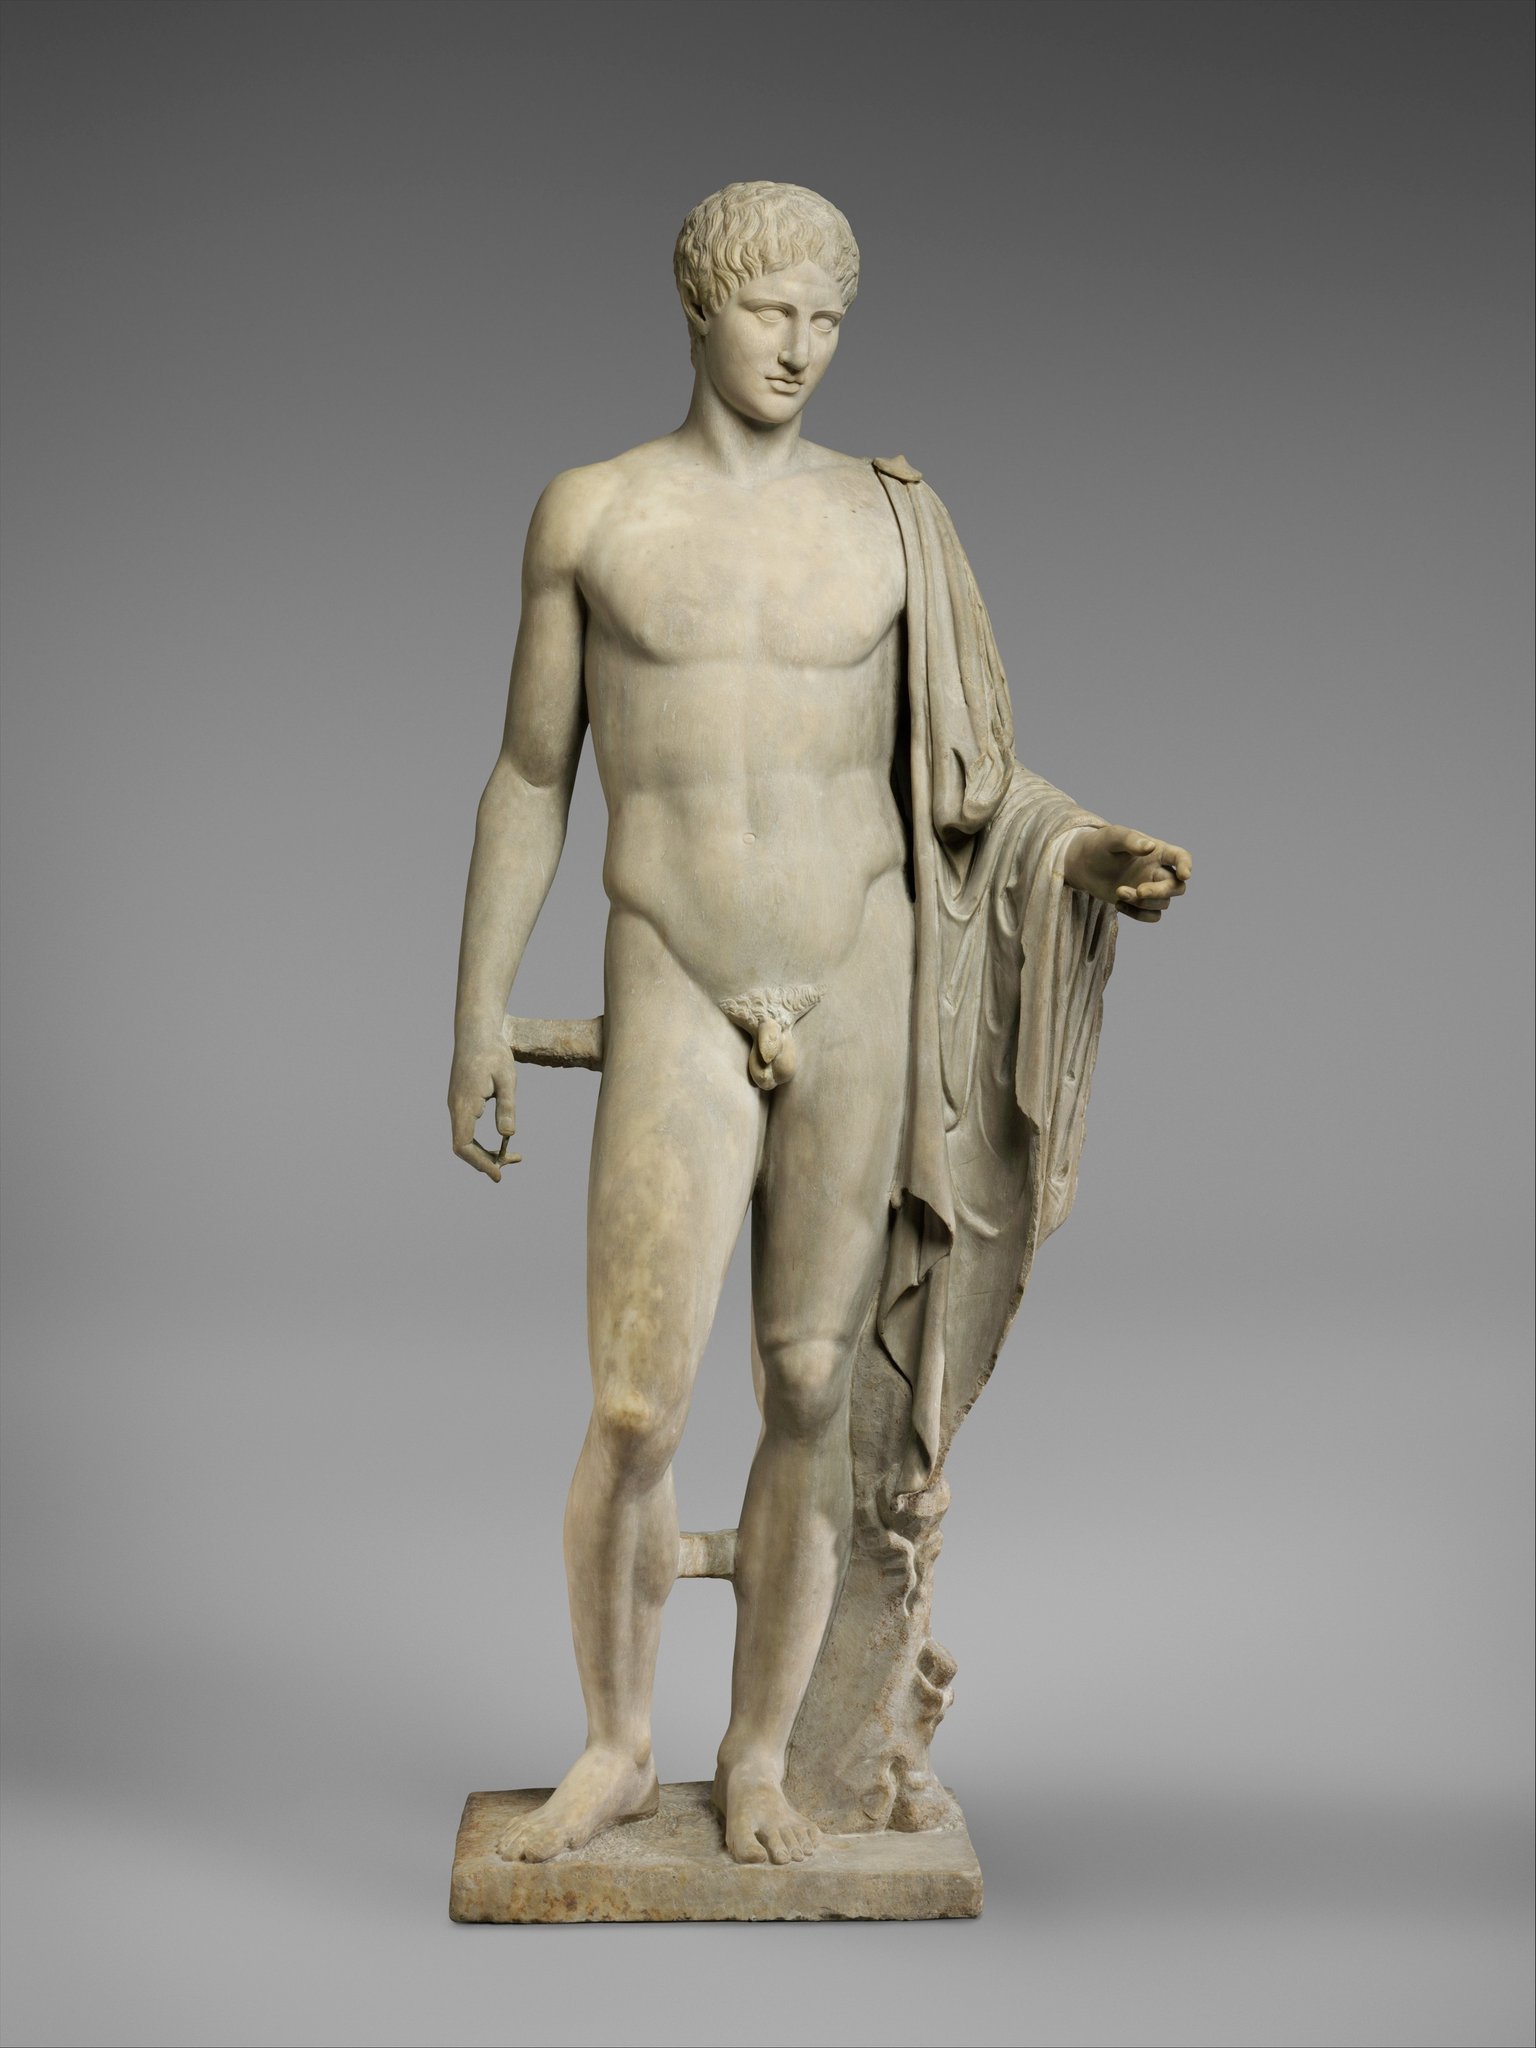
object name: statue of hermes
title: Marble statue of Hermes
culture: roman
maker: polykleitos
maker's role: artist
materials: marble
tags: hermes